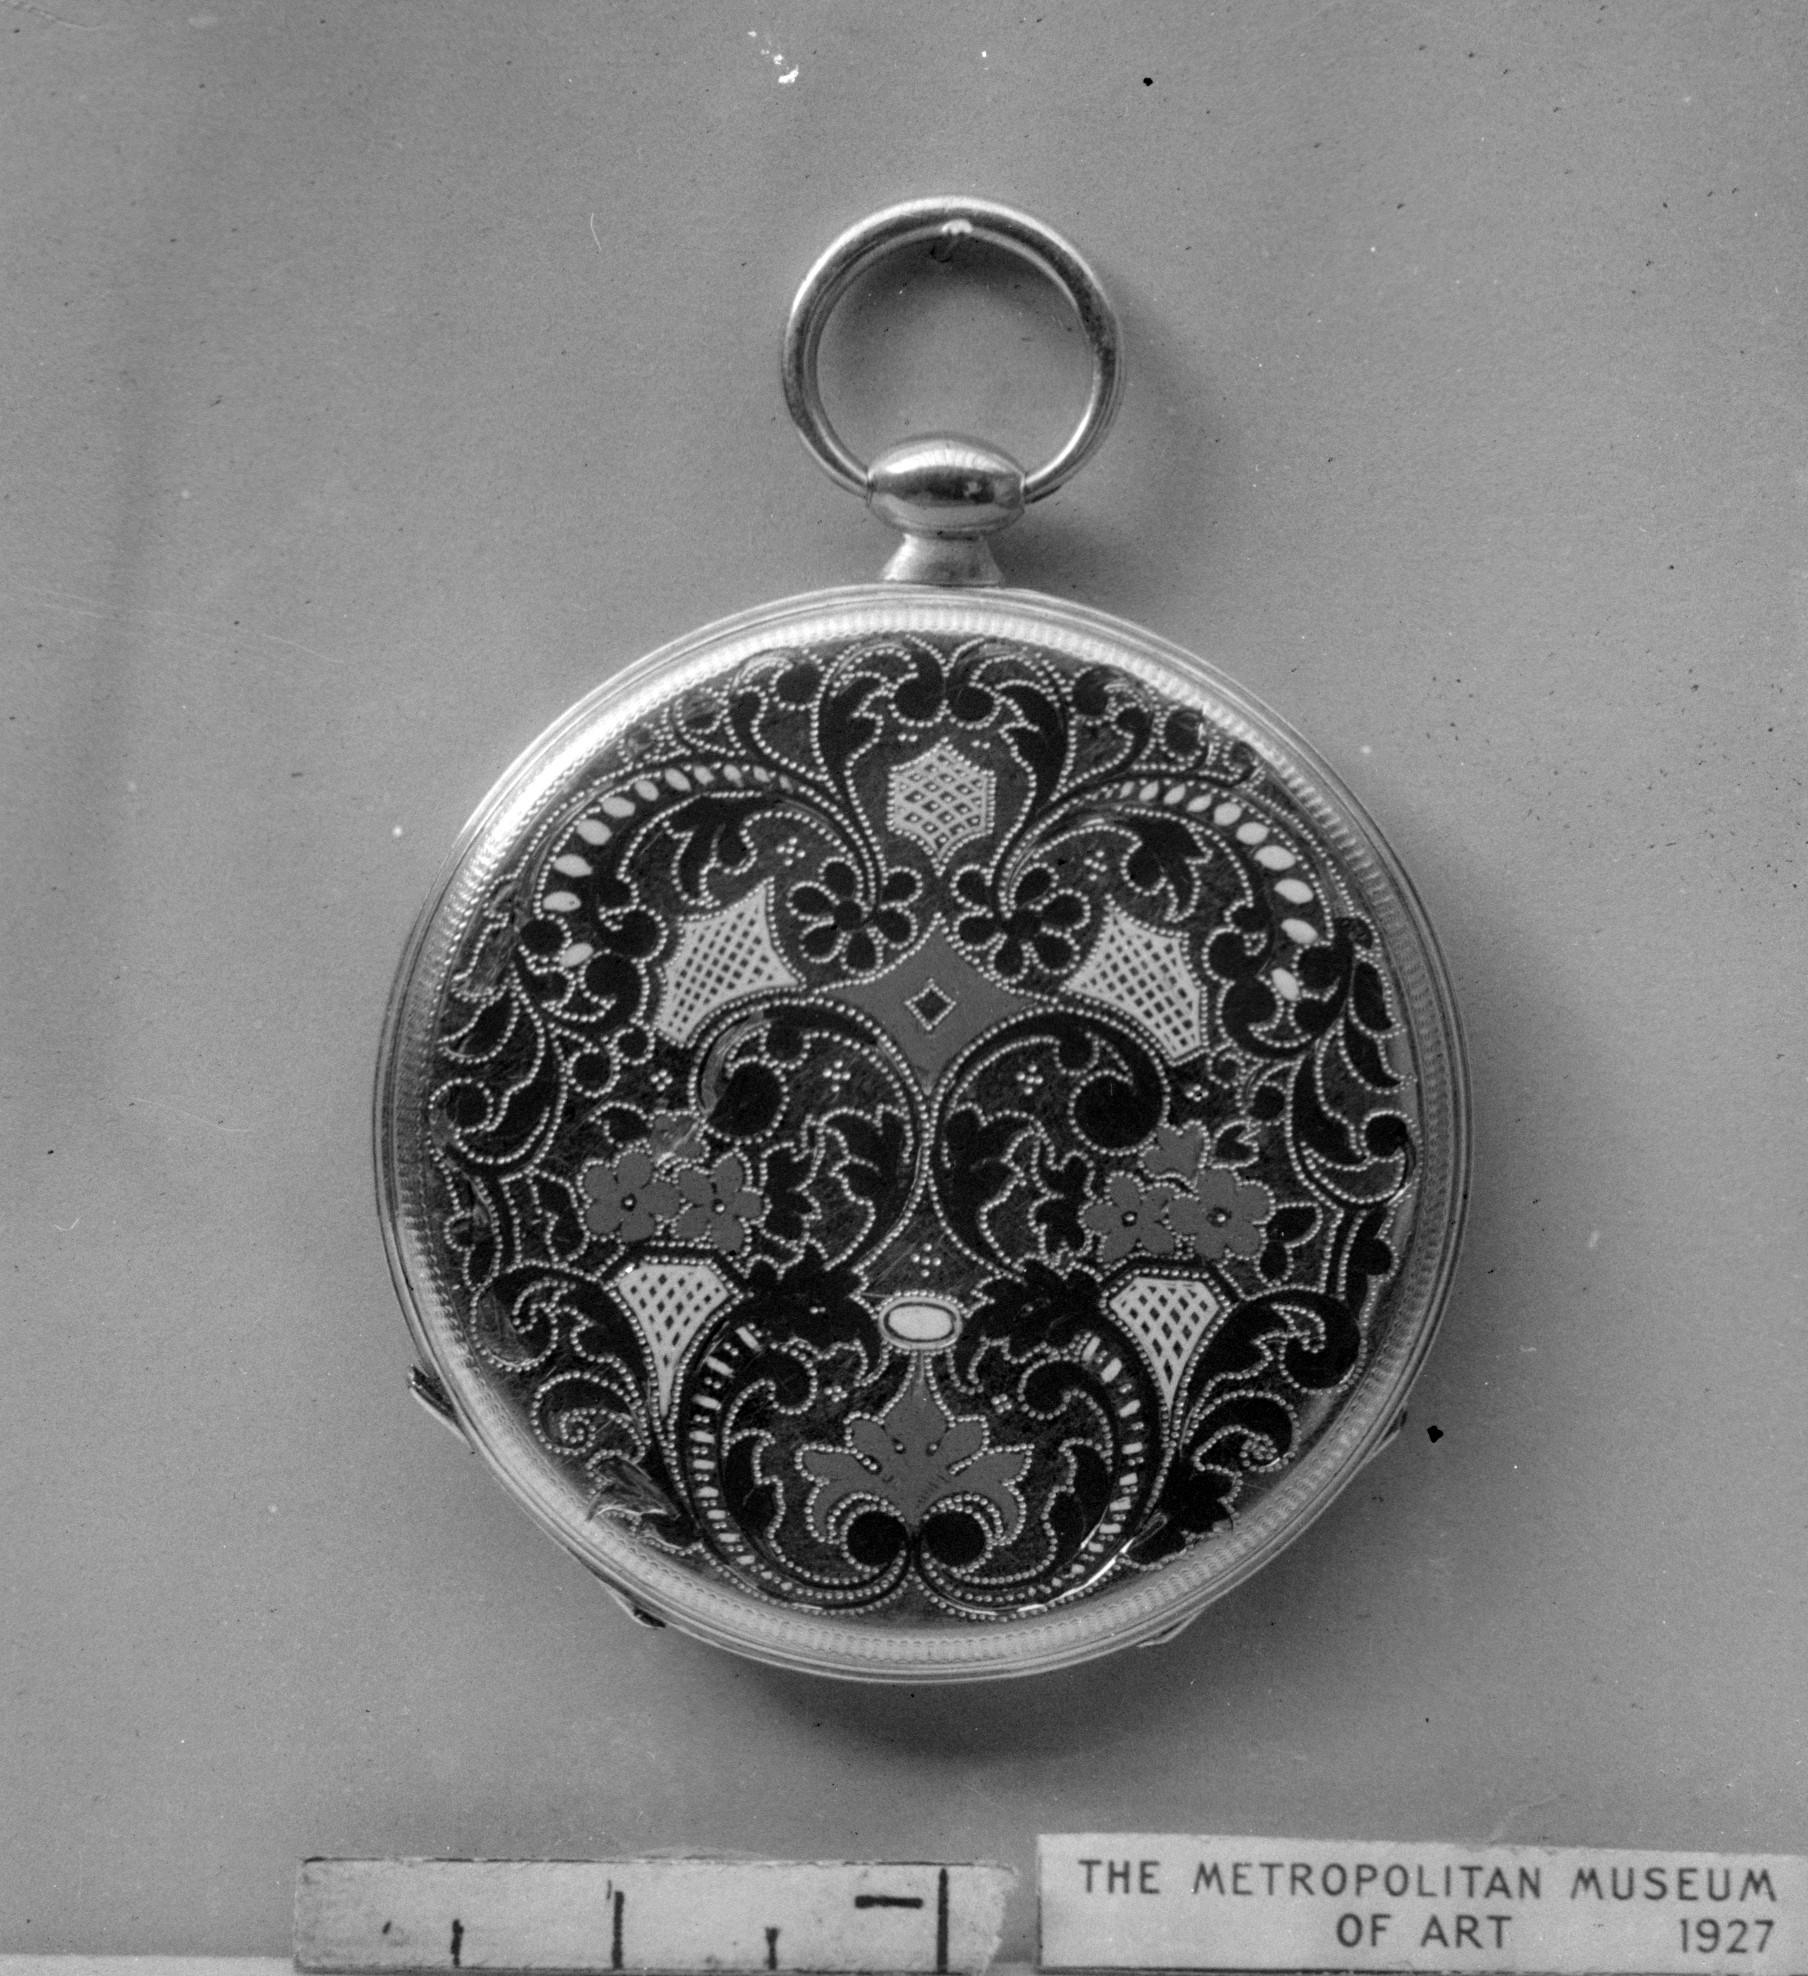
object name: watch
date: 1834-1866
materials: enamel, gold